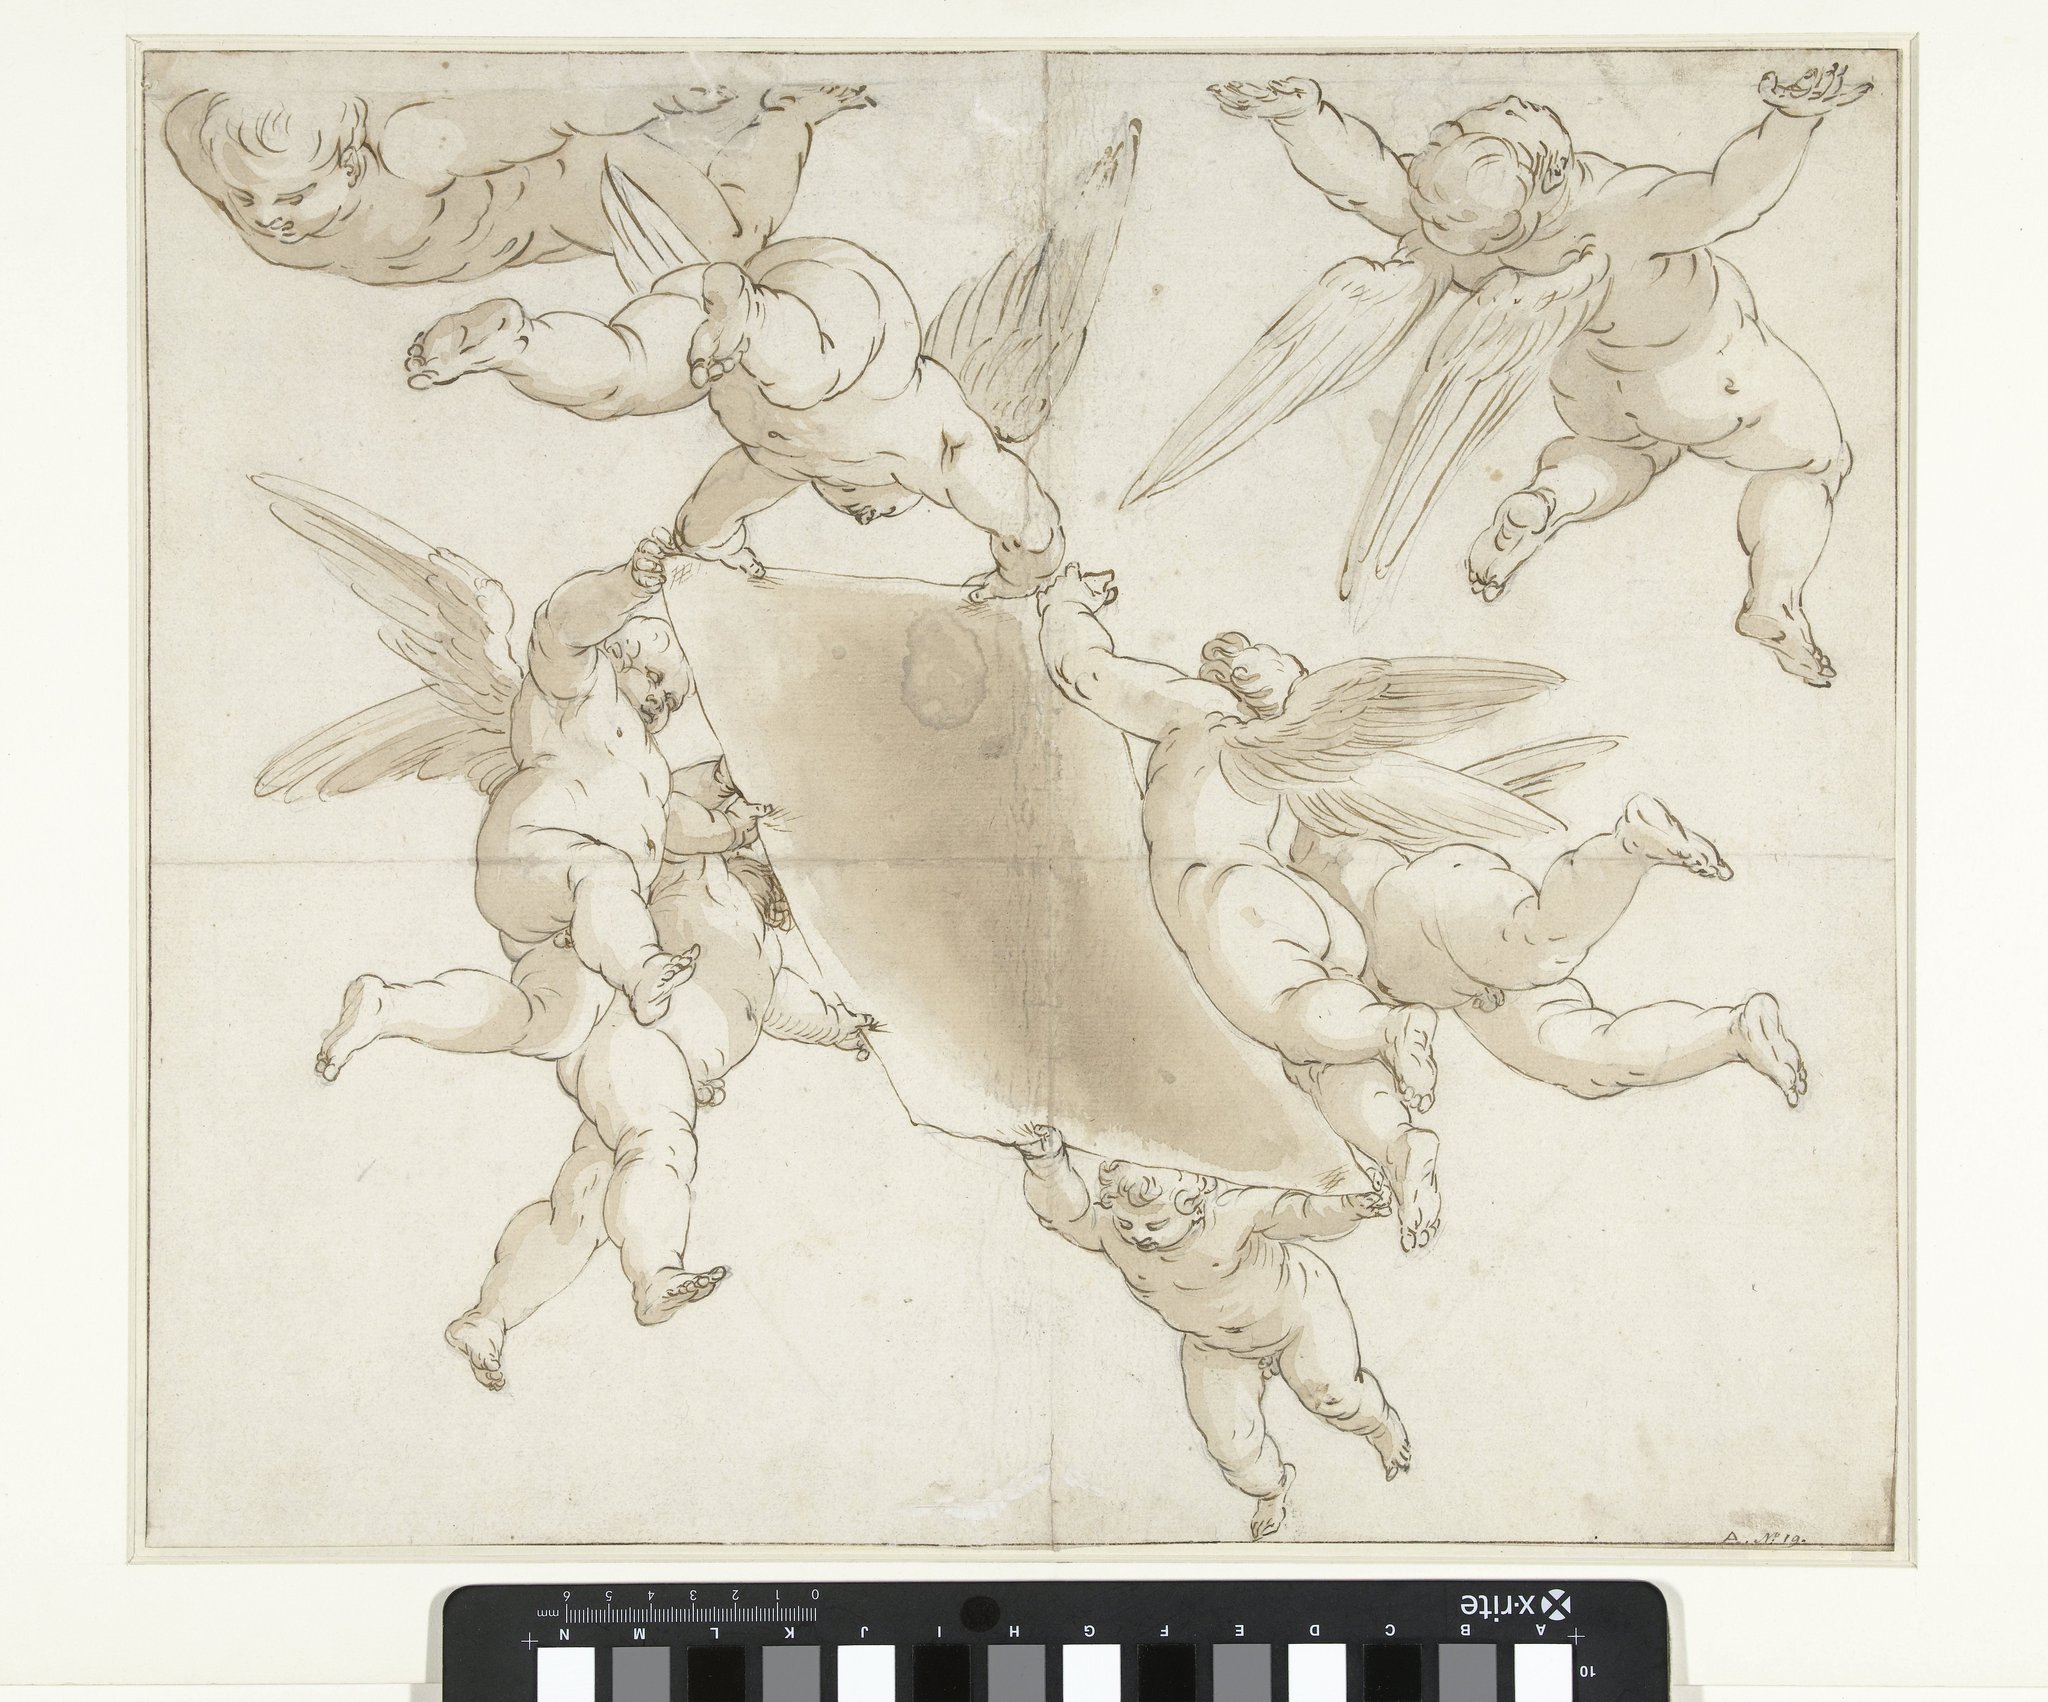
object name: drawing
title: Vliegende engeltjes met een doek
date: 1600-1699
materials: graphite, ink, paper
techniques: brush, pen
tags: angel(s) with book(-scroll) or banderole, cupids: 'amores', 'amoretti', 'putti'